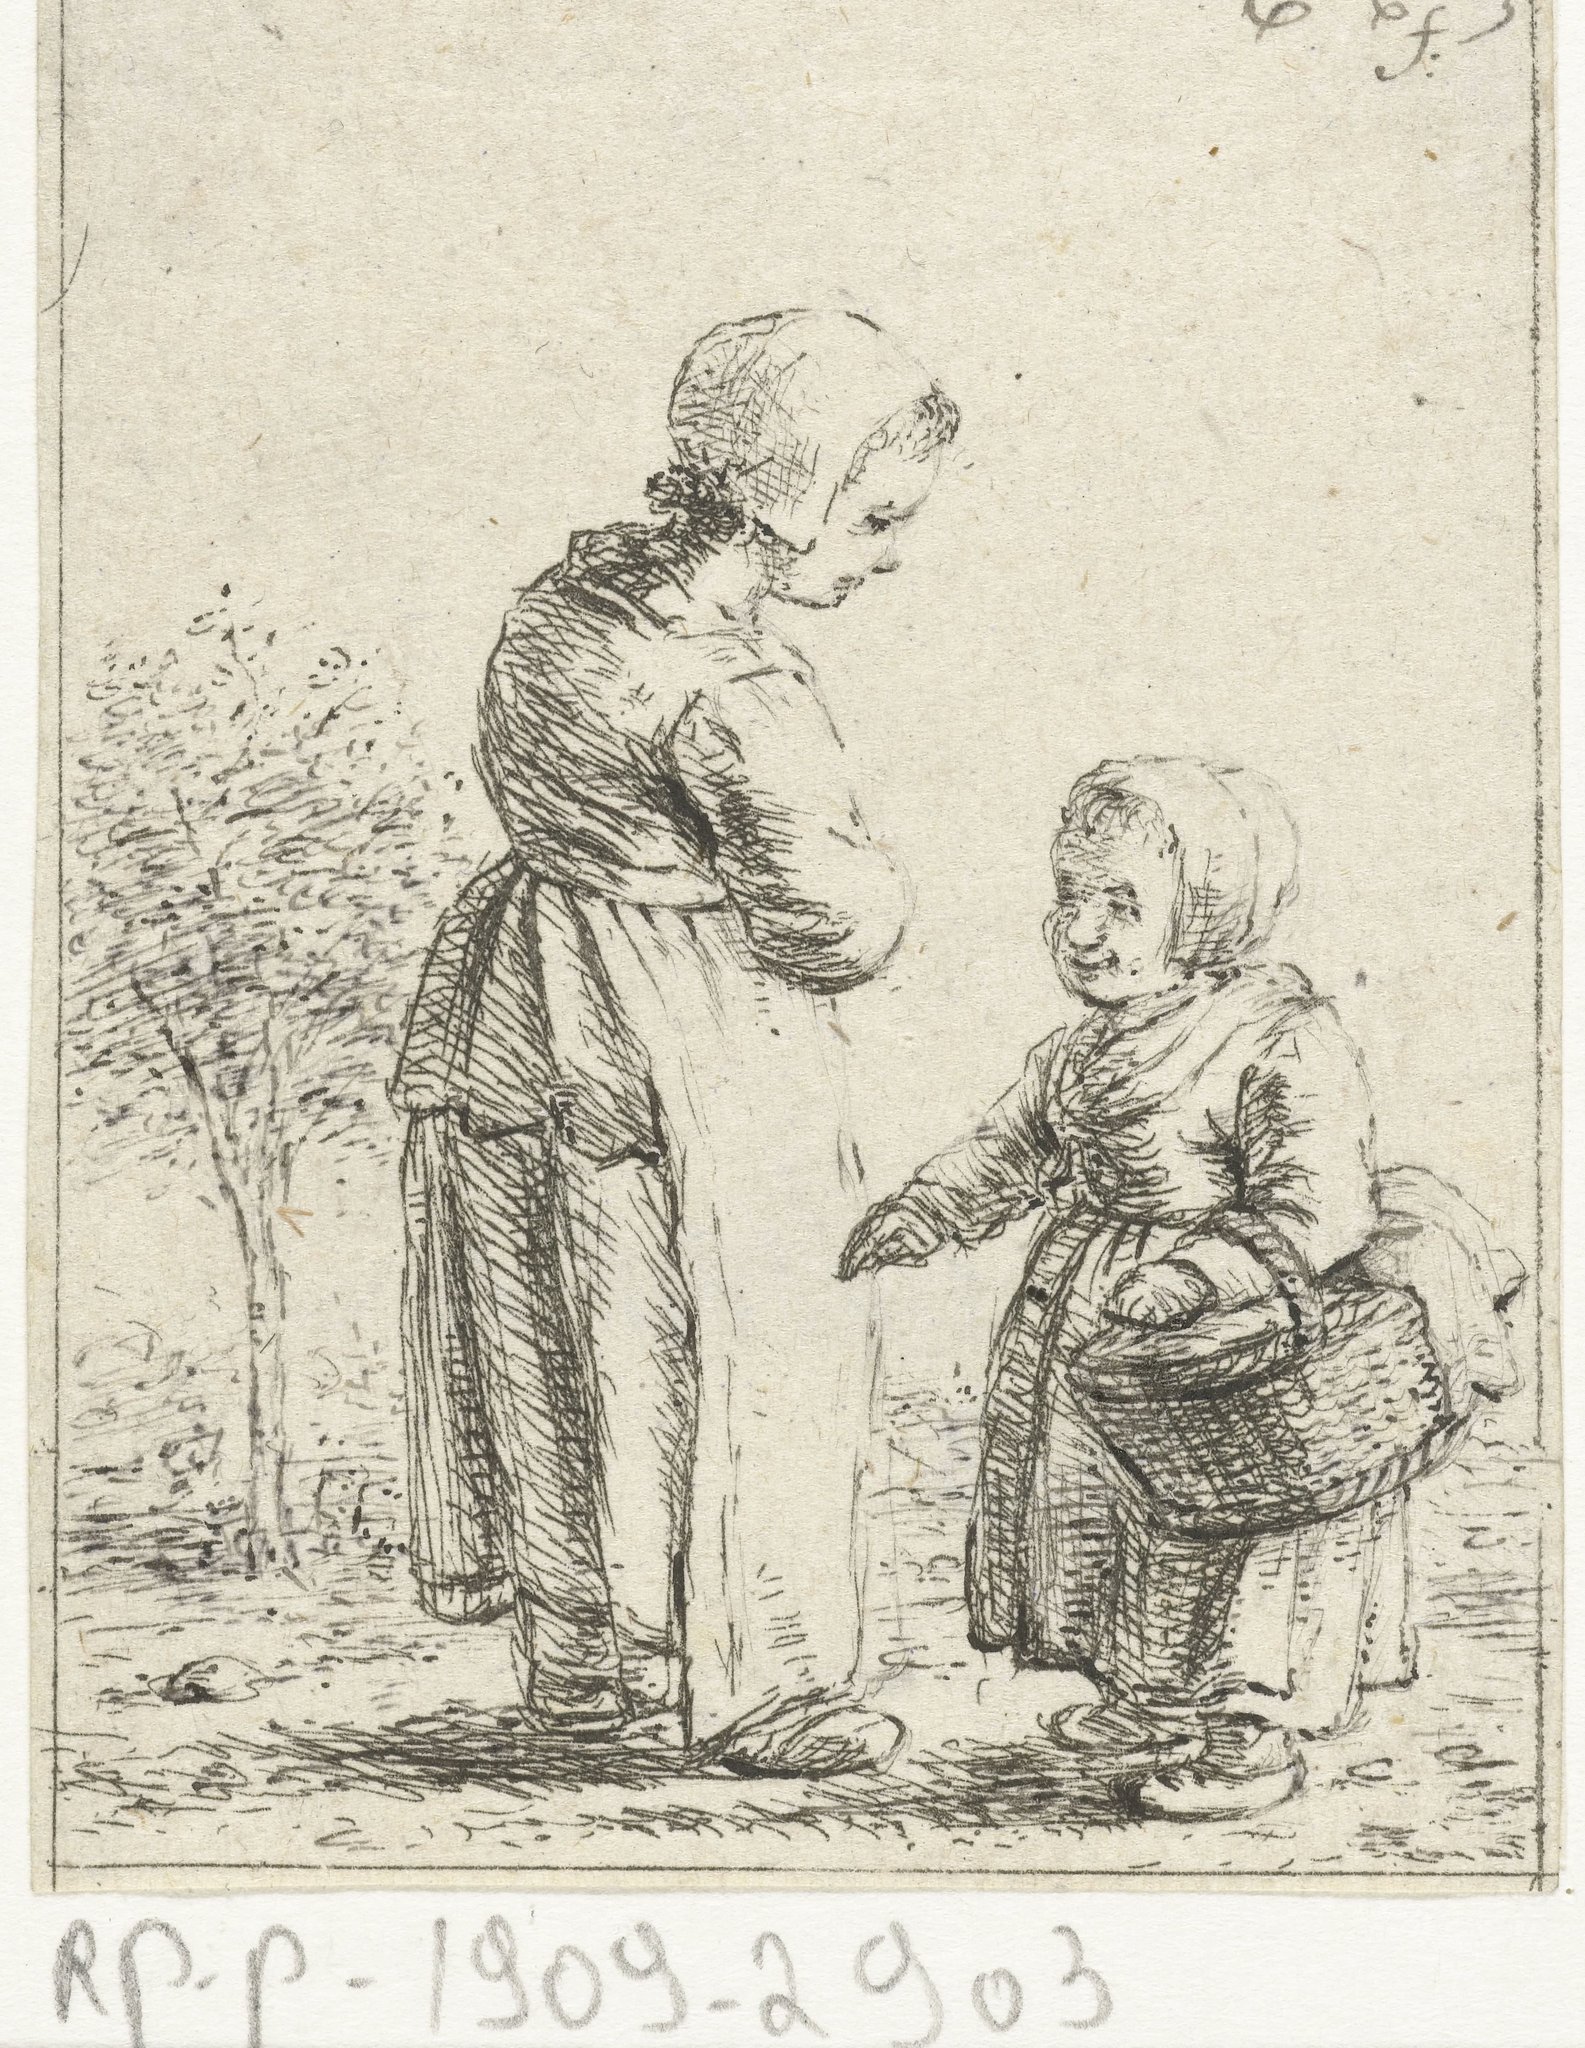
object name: print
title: Twee meisjes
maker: christina chalon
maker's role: draughtsman, print maker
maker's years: 1748-1808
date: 1758-1808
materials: paper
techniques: etching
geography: leiden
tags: carrying something in basket, bag, rucksack, etc., the (nude) human figure; 'corpo humano' (ripa) (+ young female (human being))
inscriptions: collector's mark: Lugt 2228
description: Twee meisjes. De jongste heeft een mand om de arm.